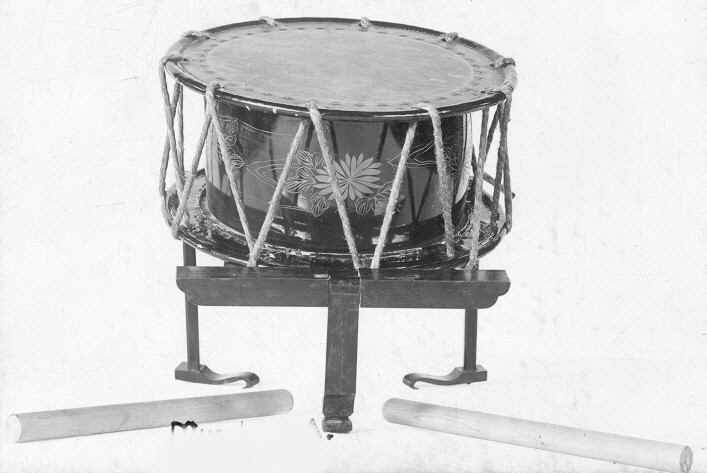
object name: taiko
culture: japanese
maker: nambuya keikichi, tokyo, asakuja, kamejima-cho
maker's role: maker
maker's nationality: japanese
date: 1801-1900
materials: metal, wood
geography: japan